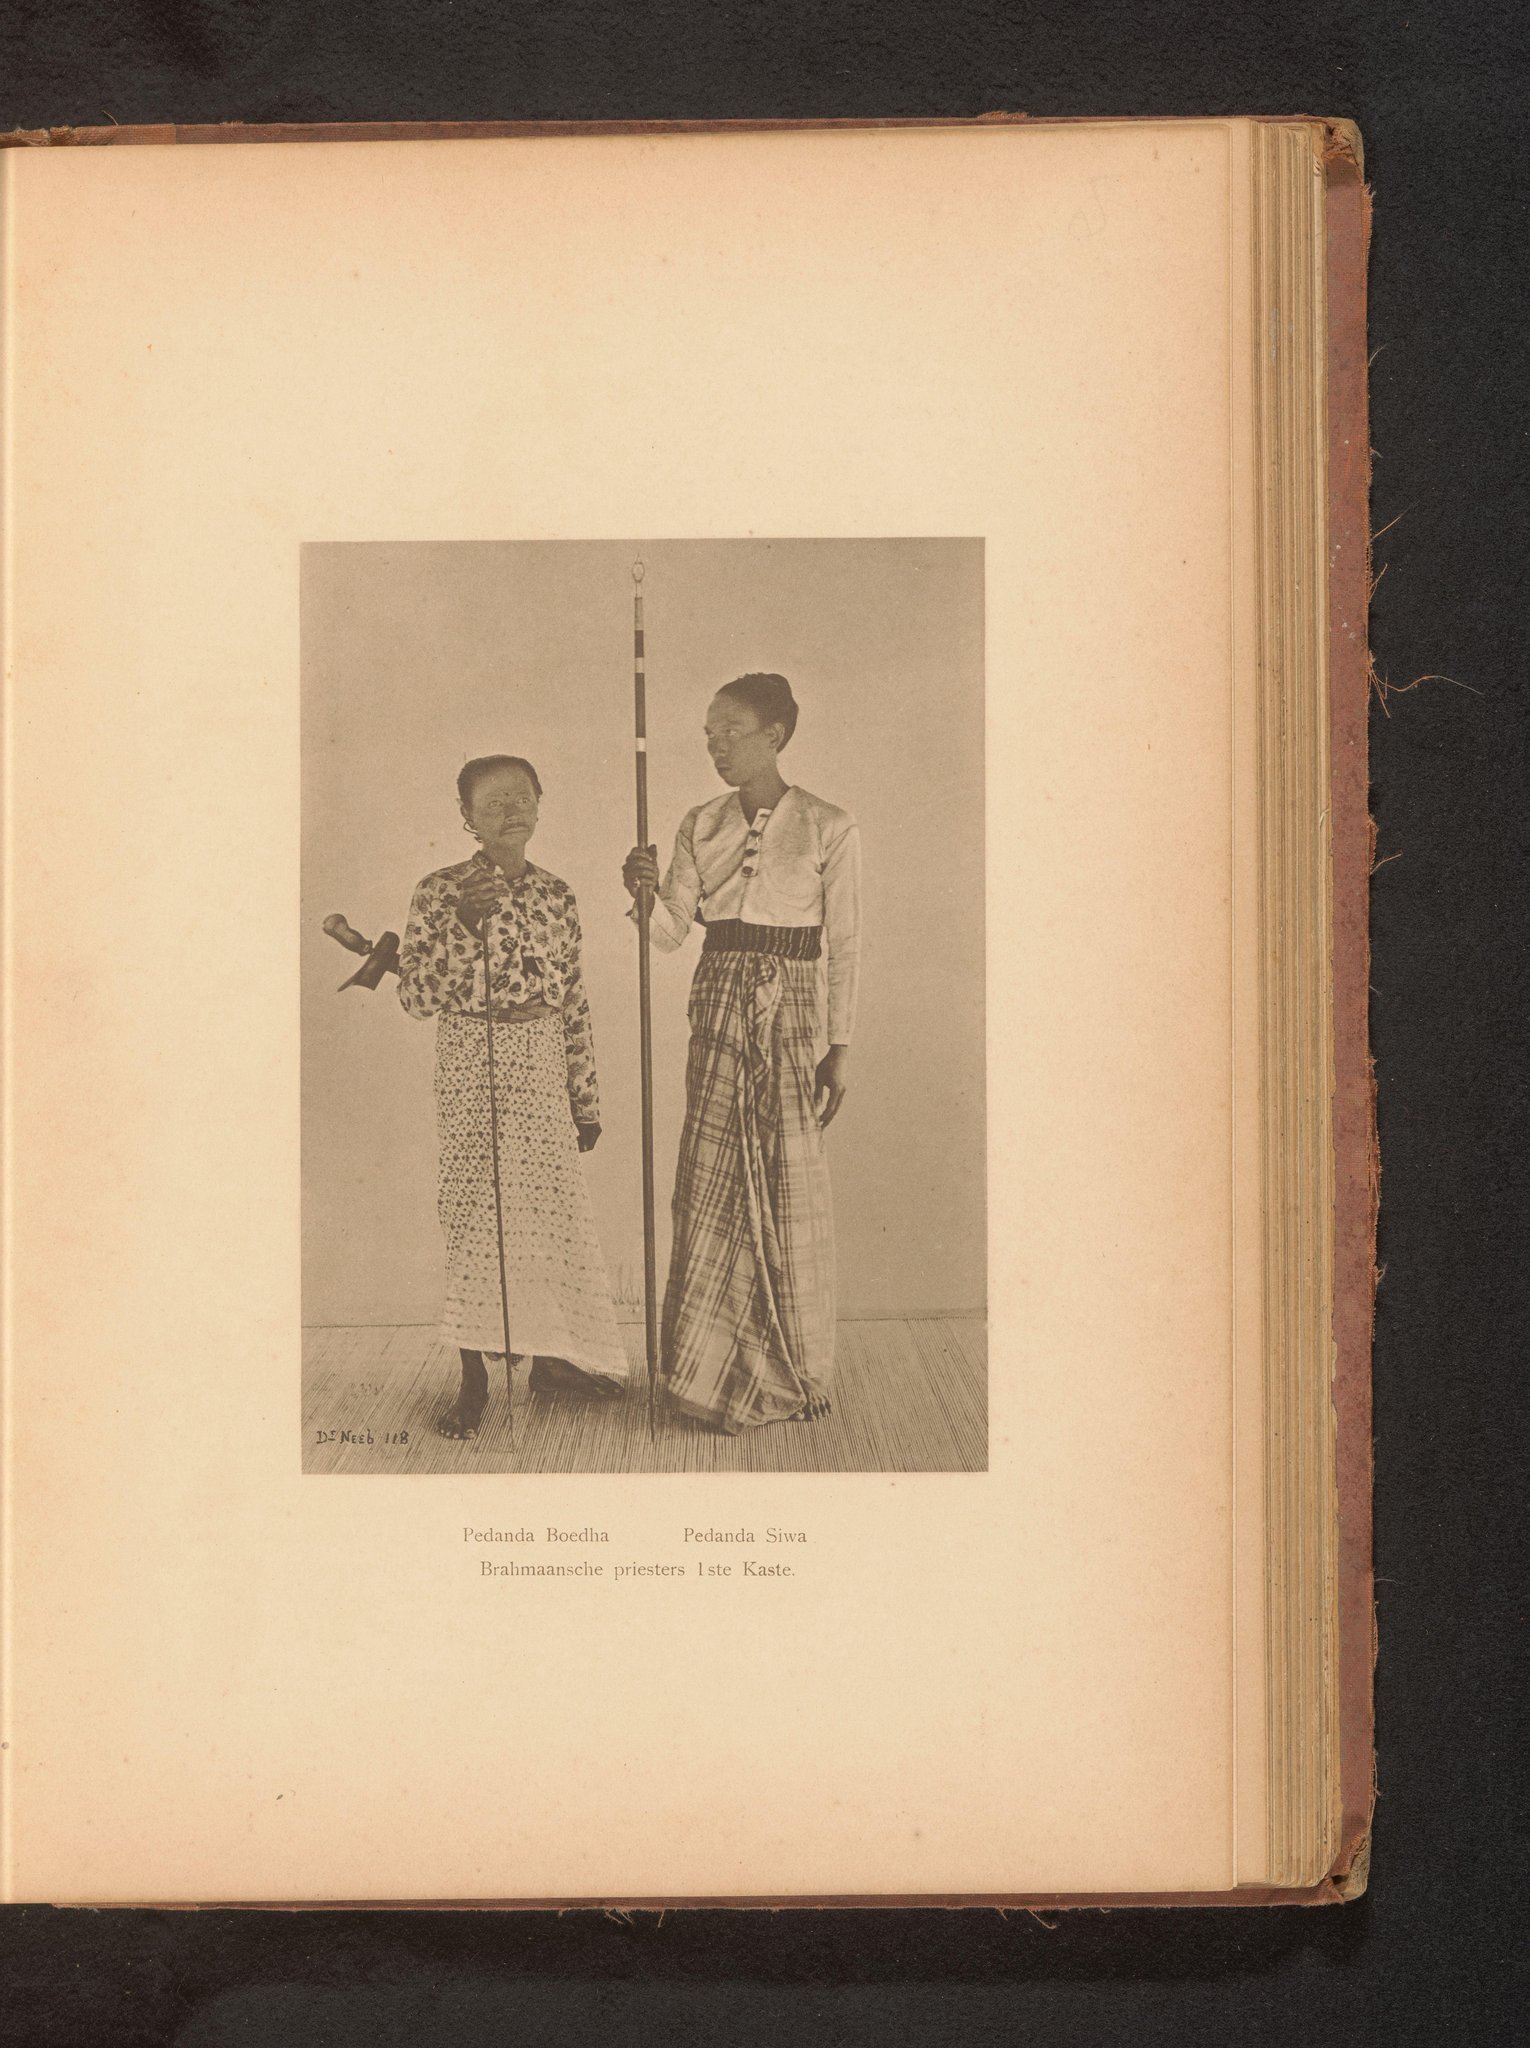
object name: photomechanical print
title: Portret van Pedanda Boedha en Pedanda Siwa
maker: christiaan johan neeb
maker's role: arts, fotograaf, officier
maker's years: 1860-1925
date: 1892-1897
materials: paper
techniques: photograph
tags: adult man, historical persons, indonesia